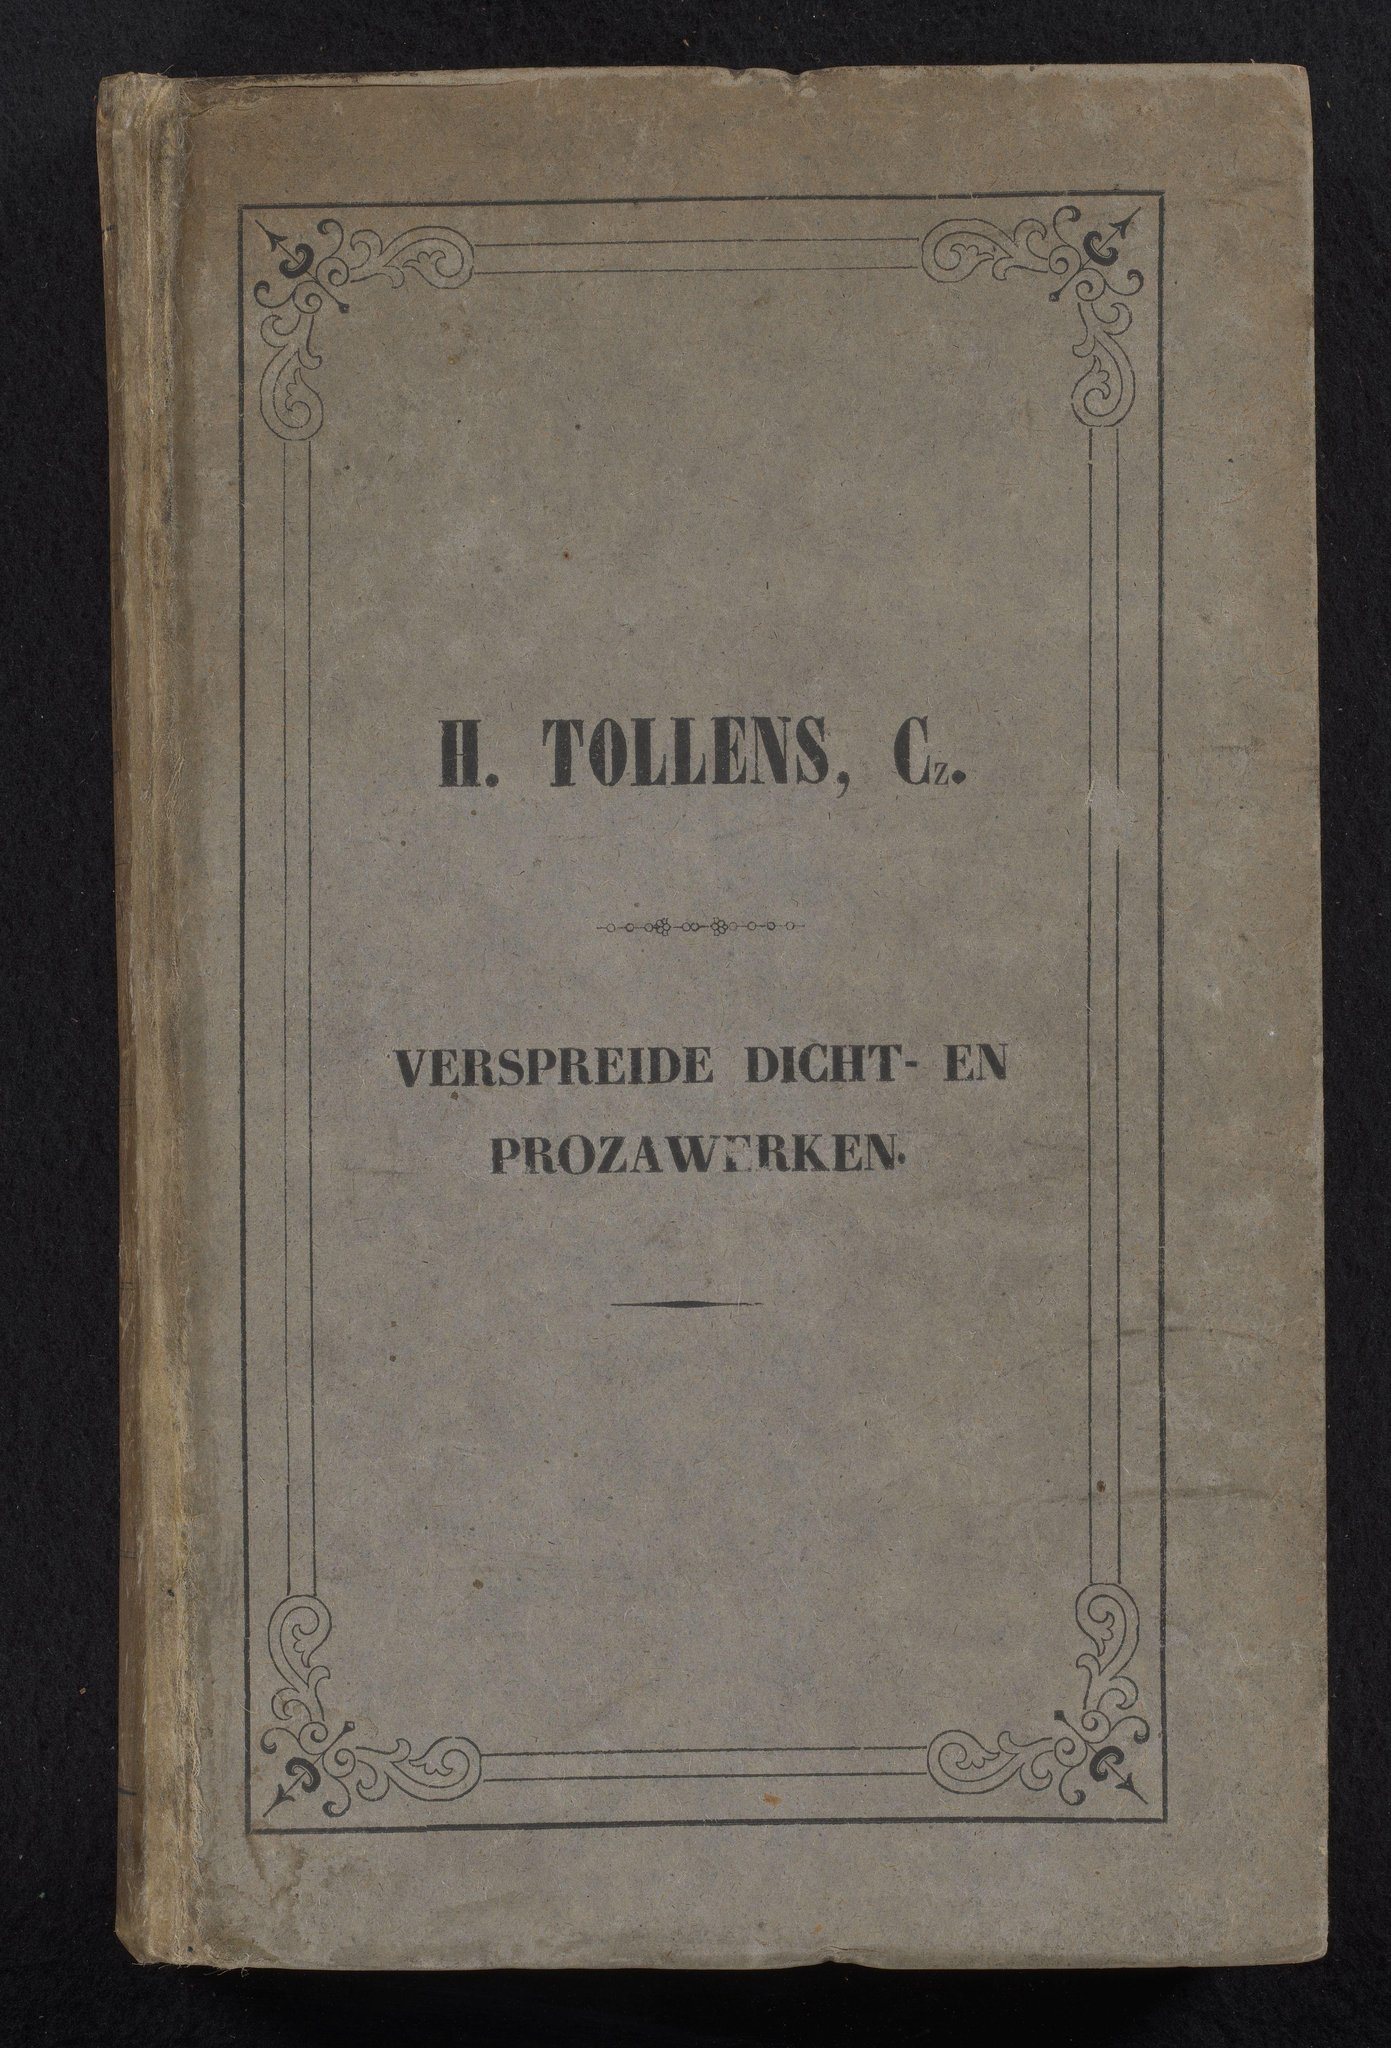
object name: book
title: Verspreide dicht- en prozawerken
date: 1861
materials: cardboard, paper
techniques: albumen print, letterpress printing, printing block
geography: antwerp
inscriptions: inscription: ‘10.-’, collector's mark: ‘BIBLIOTHEEK/ RIJKSMUSEUM/ AMSTERDAM’, inscription: ‘voor friso de jong VIII [?]’